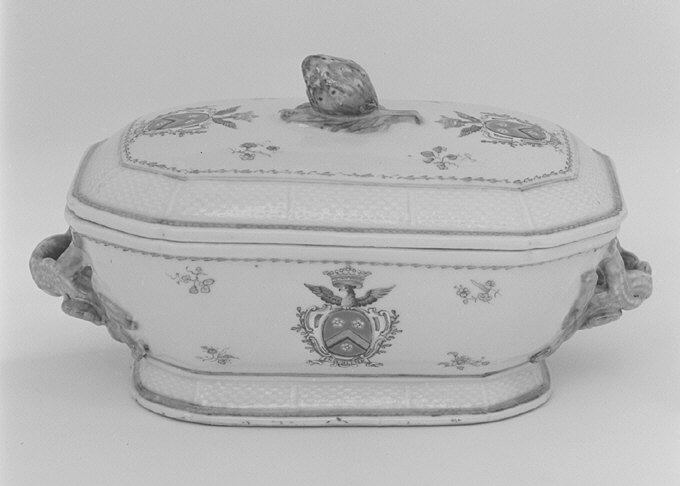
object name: tureen with cover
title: Tureen with cover (part of a service)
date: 1770-1785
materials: hard paste porcelain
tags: birds,coat of arms